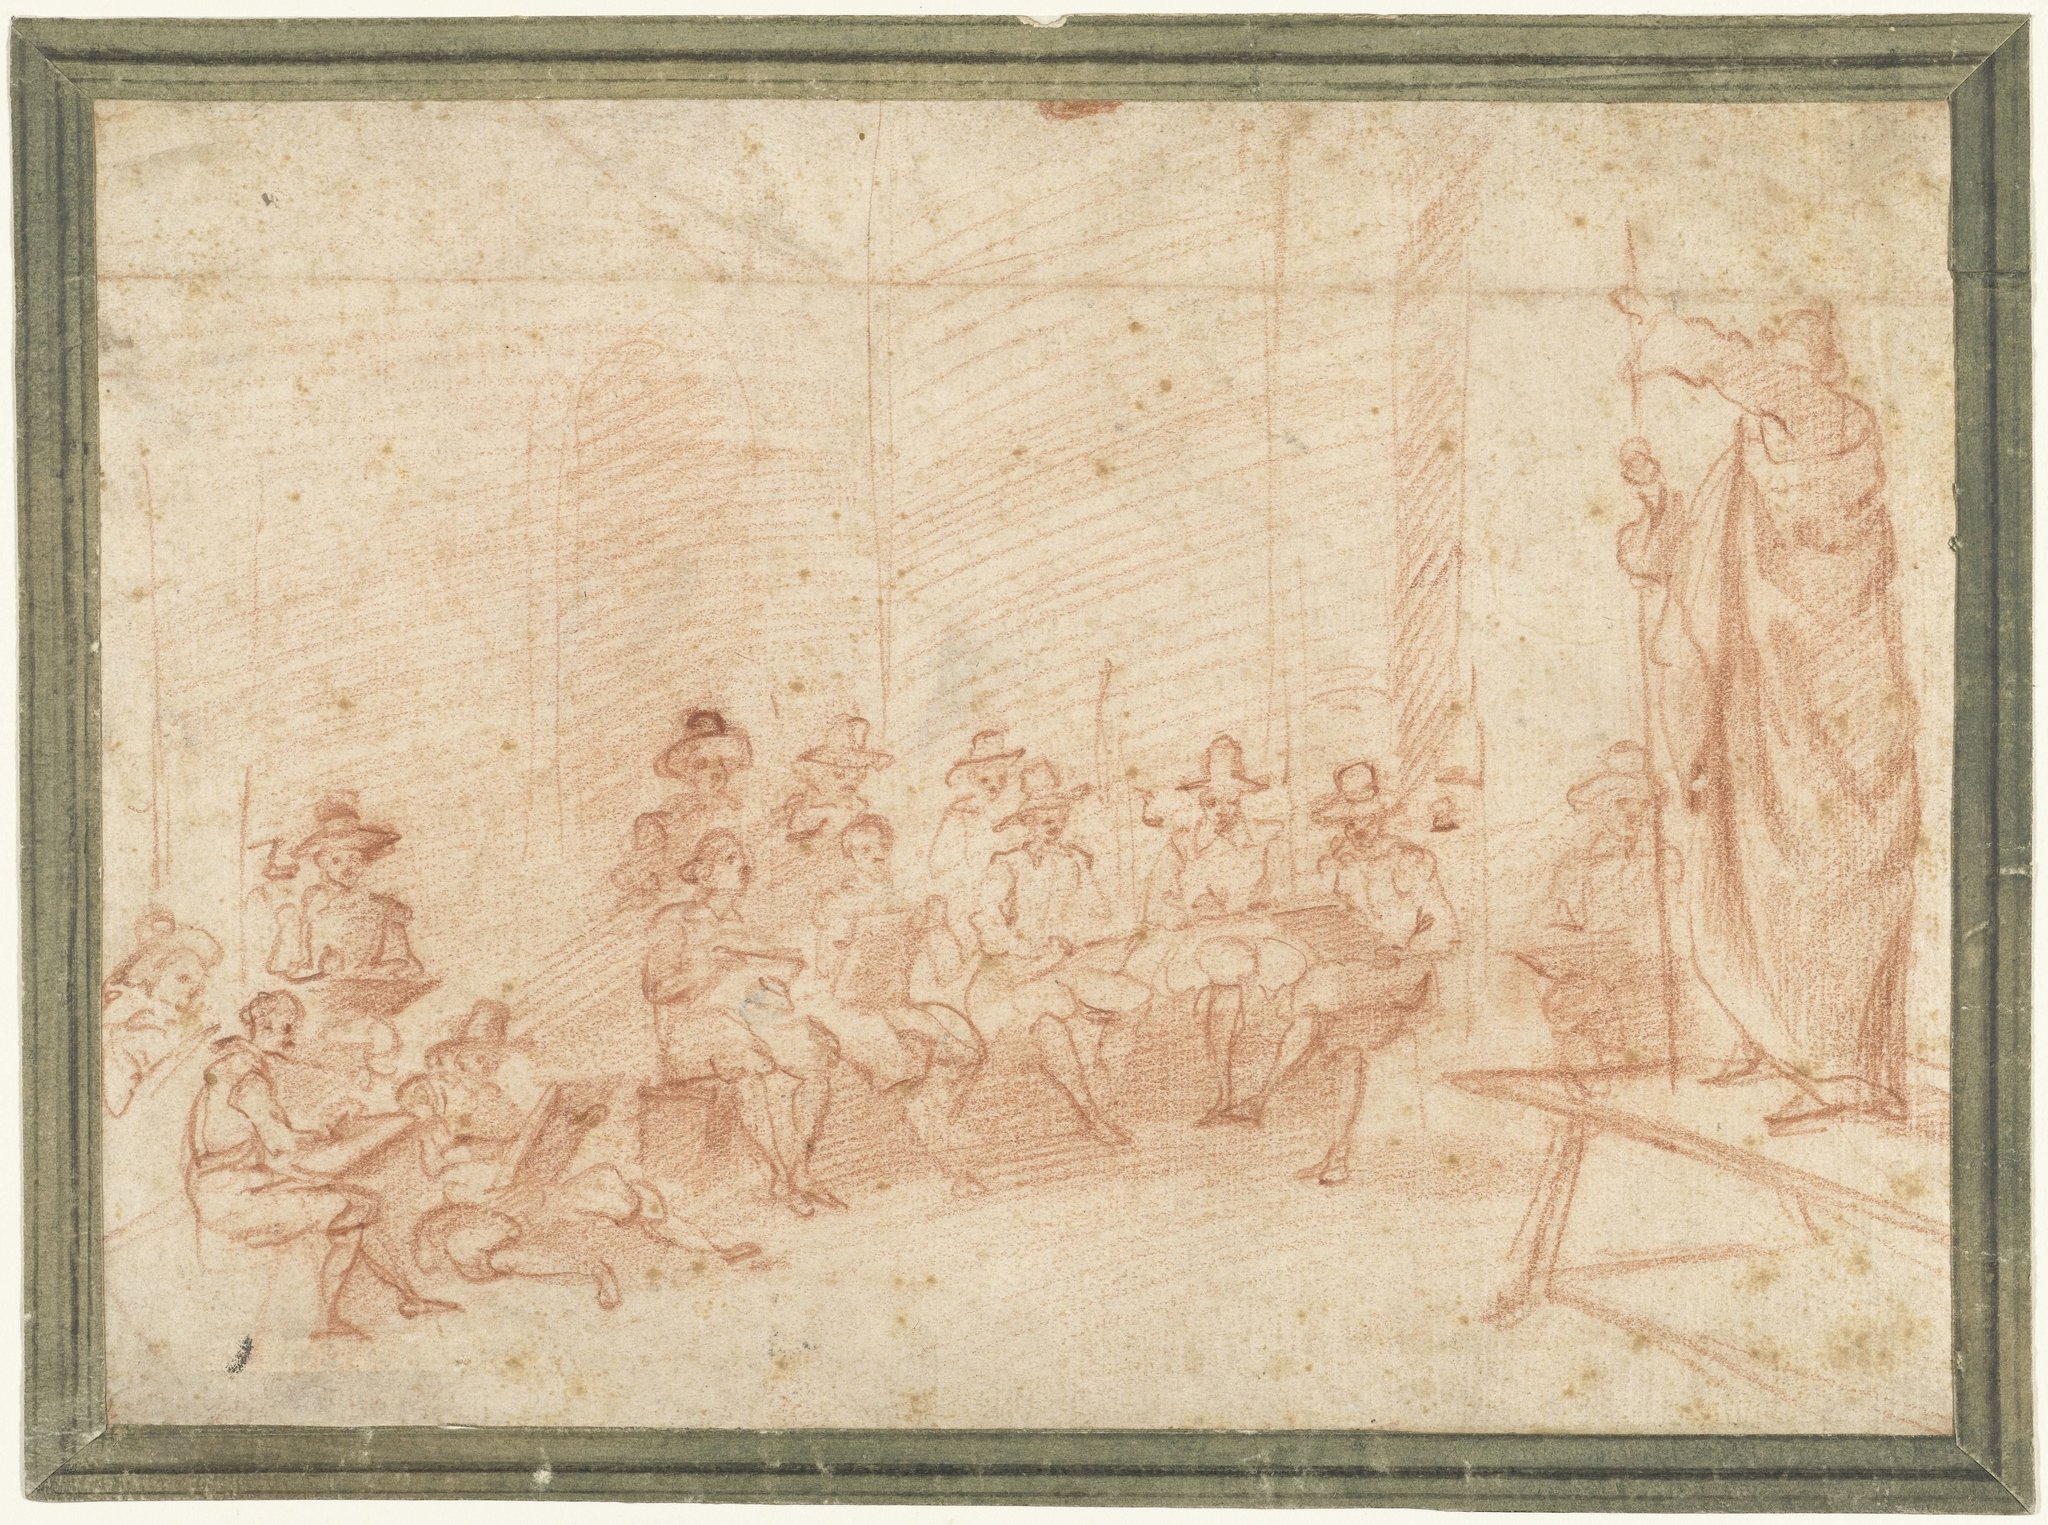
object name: drawing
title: Tekenschool waar naar bekleed model wordt getekend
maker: bernardino poccetti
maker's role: draughtsman, painter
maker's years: 1545-1612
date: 1558-1612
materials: chalk, paper